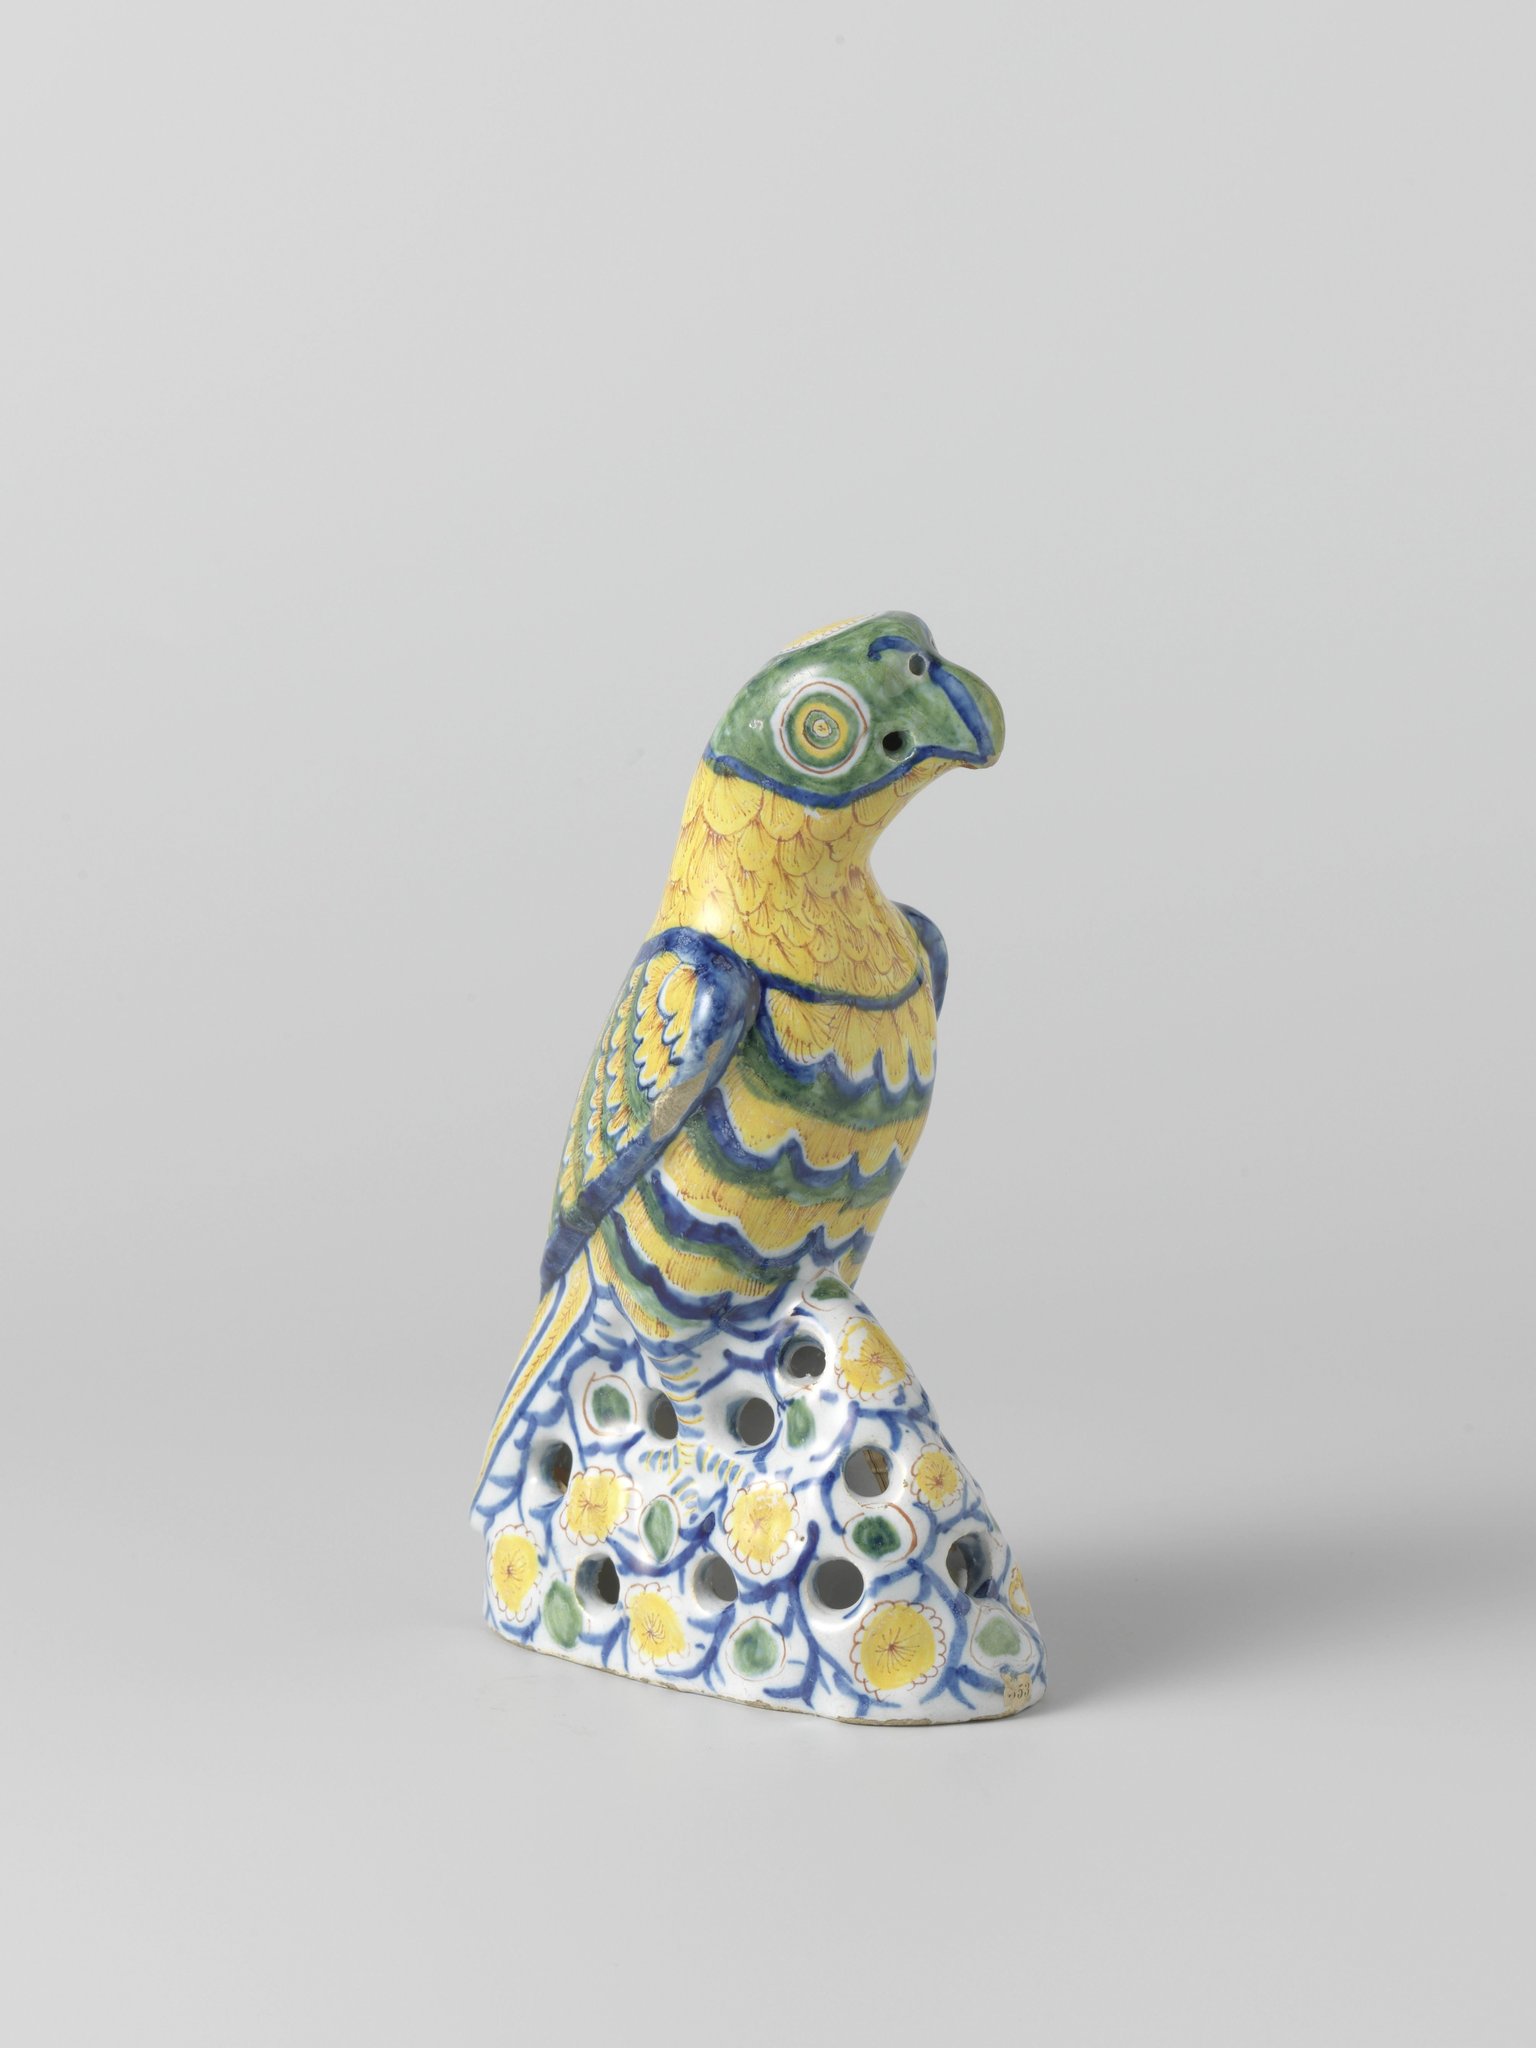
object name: decoratief object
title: Parrot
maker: Anonymous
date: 1729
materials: earthenware, glaze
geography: delft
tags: ornamental birds: parrot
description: Dierenfiguur van faïence, in de vorm van een papegaai. Veelkleurig beschilderd.